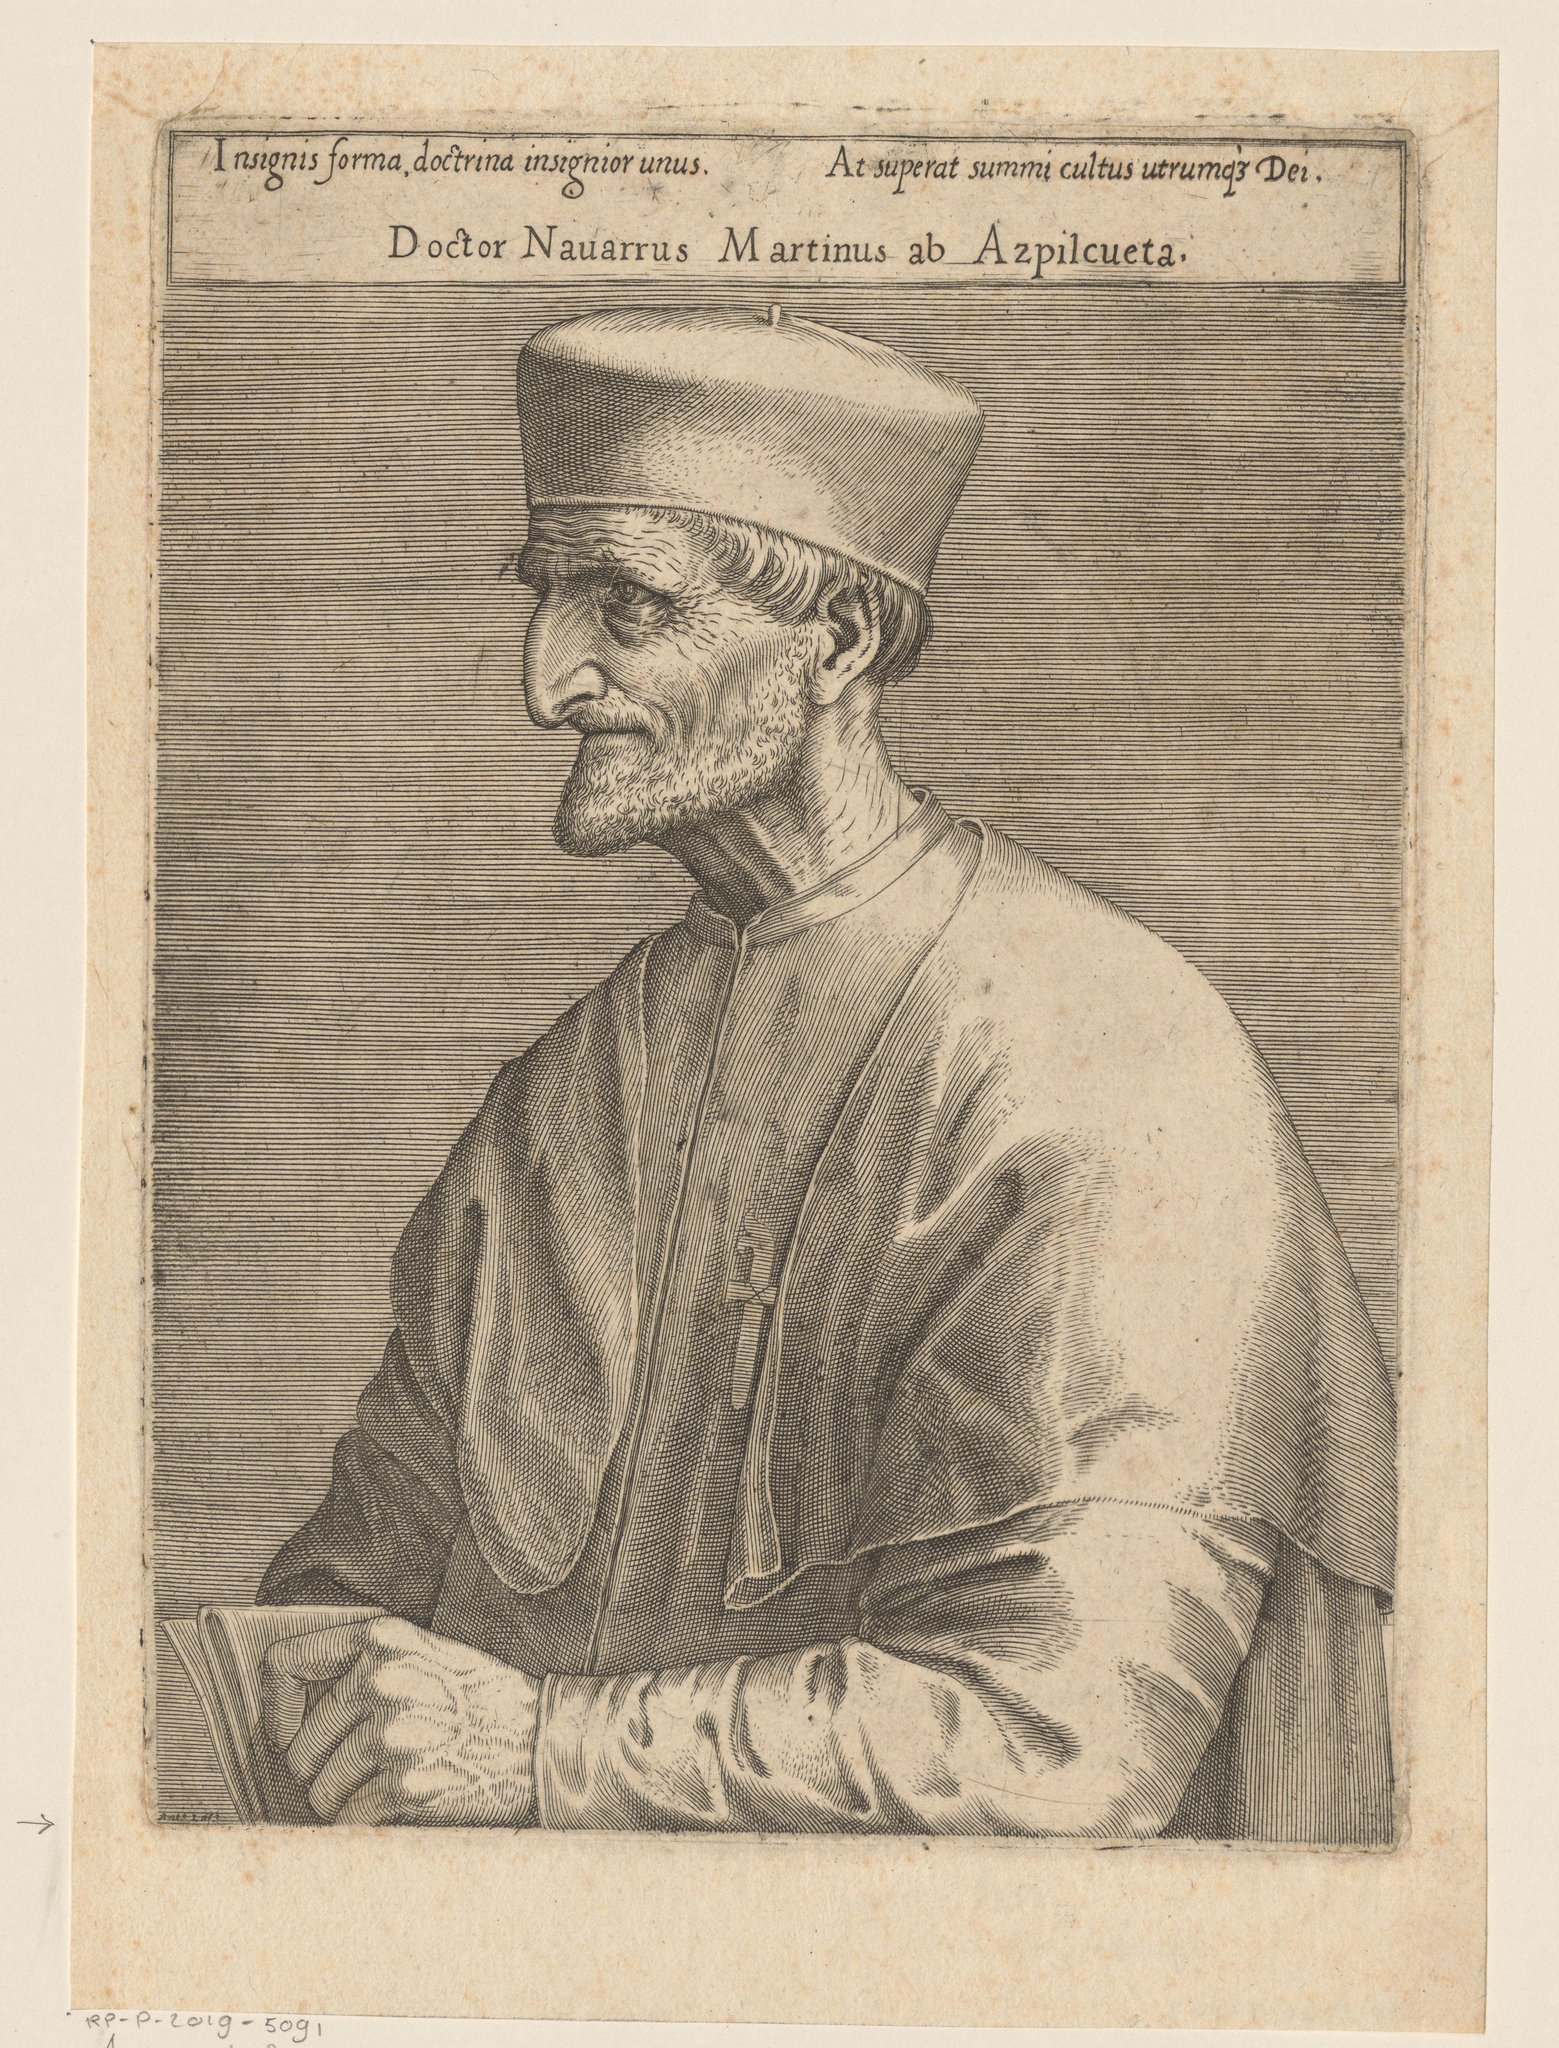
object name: print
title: Portret van Martín de Azpilcueta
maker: antonio lafreri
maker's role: publisher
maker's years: 1512-1577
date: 1566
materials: paper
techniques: engraving, etching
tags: spain, rome, priest, historical persons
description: Prent mogelijk uit: Benavides, Marco Mantova. Illustrium jureconsultorum imagines quae inveniri potuerunt ad vivam effigiem expressae (...). Rome: Antonio Lafreri, 1566. Prentserie waarschijnlijk opnieuw uitgegeven door Petri de' Nobili rond 1584-1585.